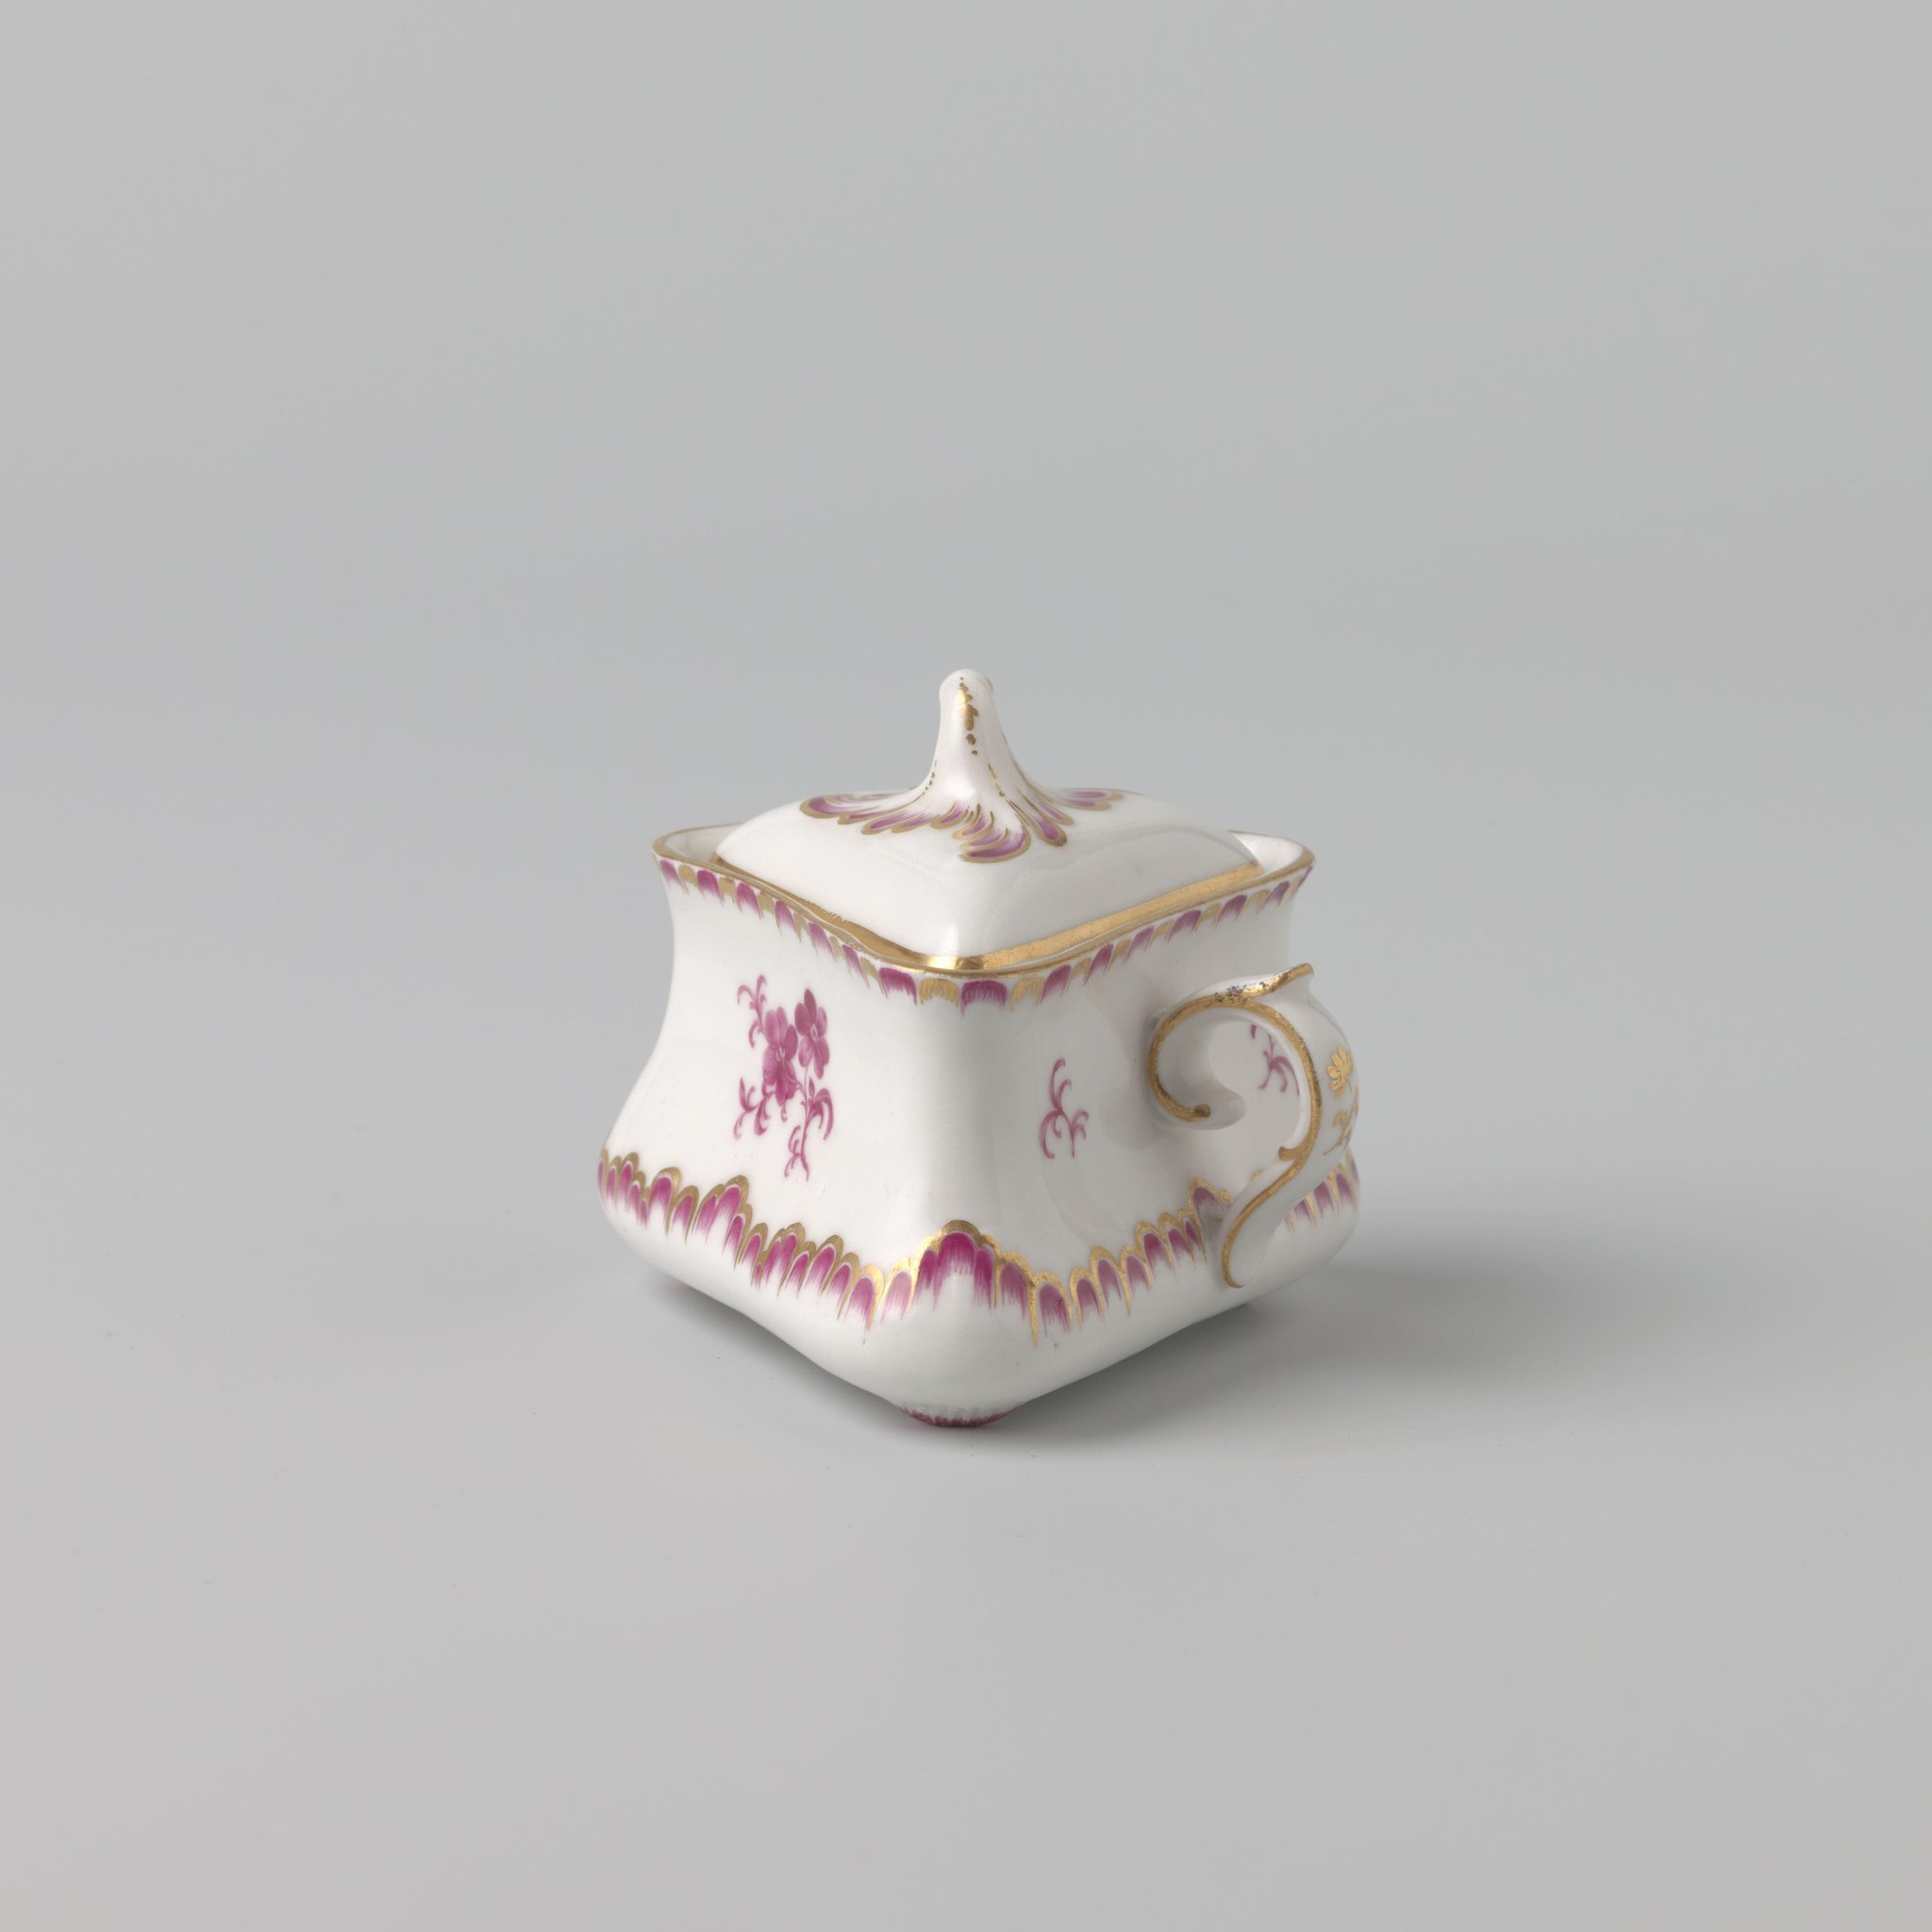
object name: roompot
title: Roompot, beschilderd met bloemtakken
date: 1774-1778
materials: porcelain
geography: loosdrecht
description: Roompot van porselein. Driehoekig met vraagtekenvormig oor en ingesnoerde wand. Langs de voetrand rocaille ornament in reliëf. Beschilderd in bietenrood met bloemtakjes. De mond¬ en voetrand zijn versierd in bietenrood en goud. Op het oor een bloemtakje in goud. Gouden biezen langs oor en mond- en dekselrand.